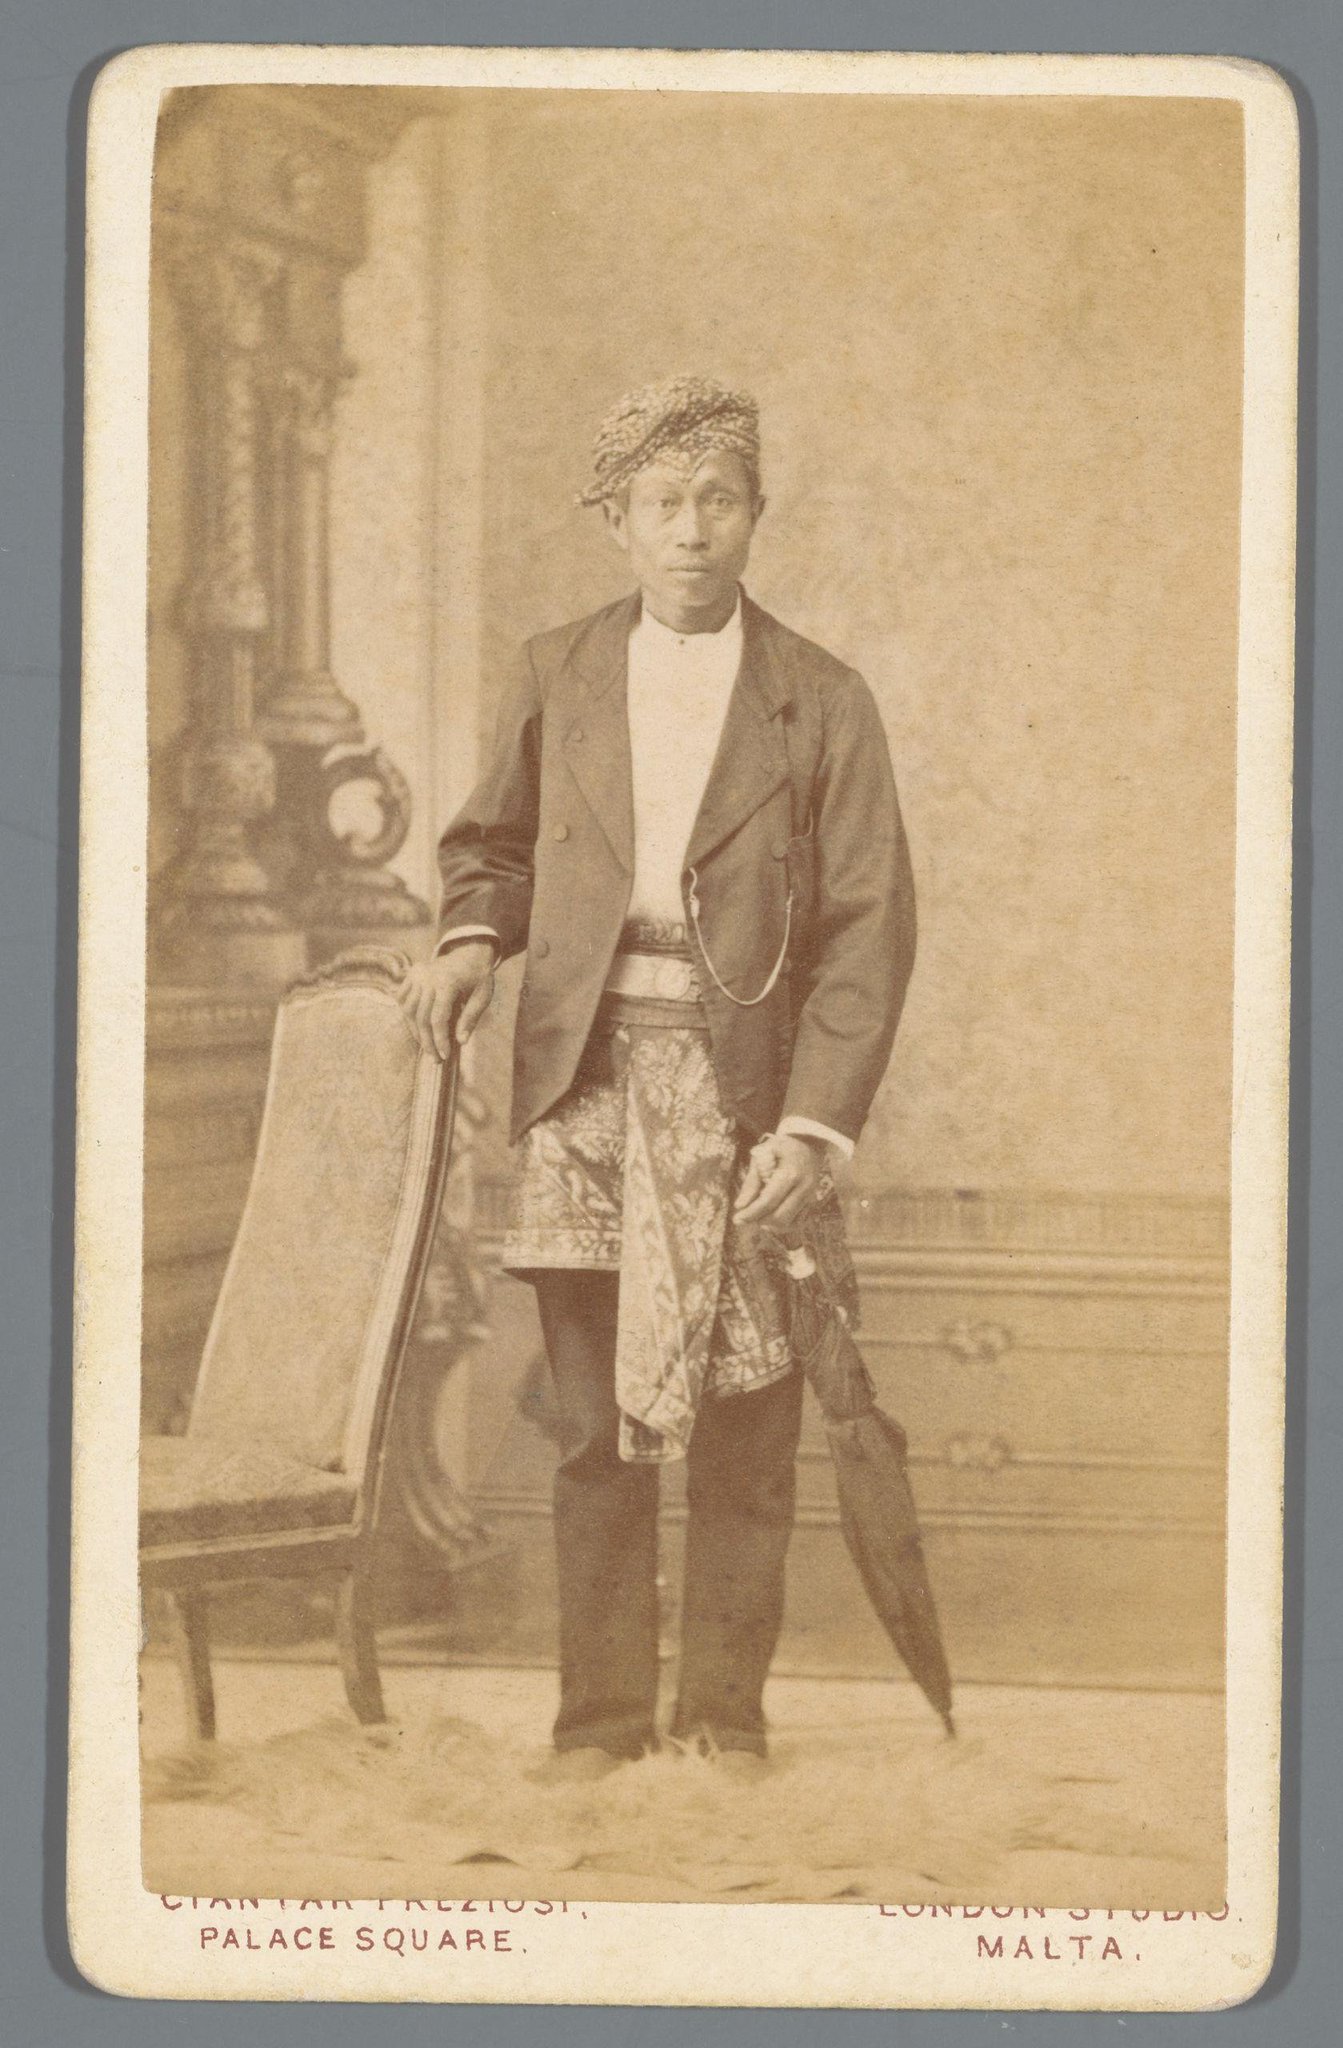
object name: photograph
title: Portret van een Indonesische man in Javaanse en westerse kleding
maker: saverio ciantar preziosi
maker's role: fotograaf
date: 1855-1885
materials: cardboard, paper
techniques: albumen print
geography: valletta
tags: adult man, anonymous historical person portrayed, umbrella, folk costume, regional costume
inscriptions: inscription: ‘Ciantar Preziosi. London Studio./ Palace Square. Malta.’, inscription: ‘London/ Studio/ Ciantar Preziosi/ late/ Davison & Ciantar Preziosi/ Photographer/ 133 Strada Teatro/ 134 Strada Stretta/ & Palace Square/ Valetta Malta/ This Portrait may be had/ enlarged to life size & can/ be finishe in Carbon, Crayon,/ Opal Oil or Water Colours.’